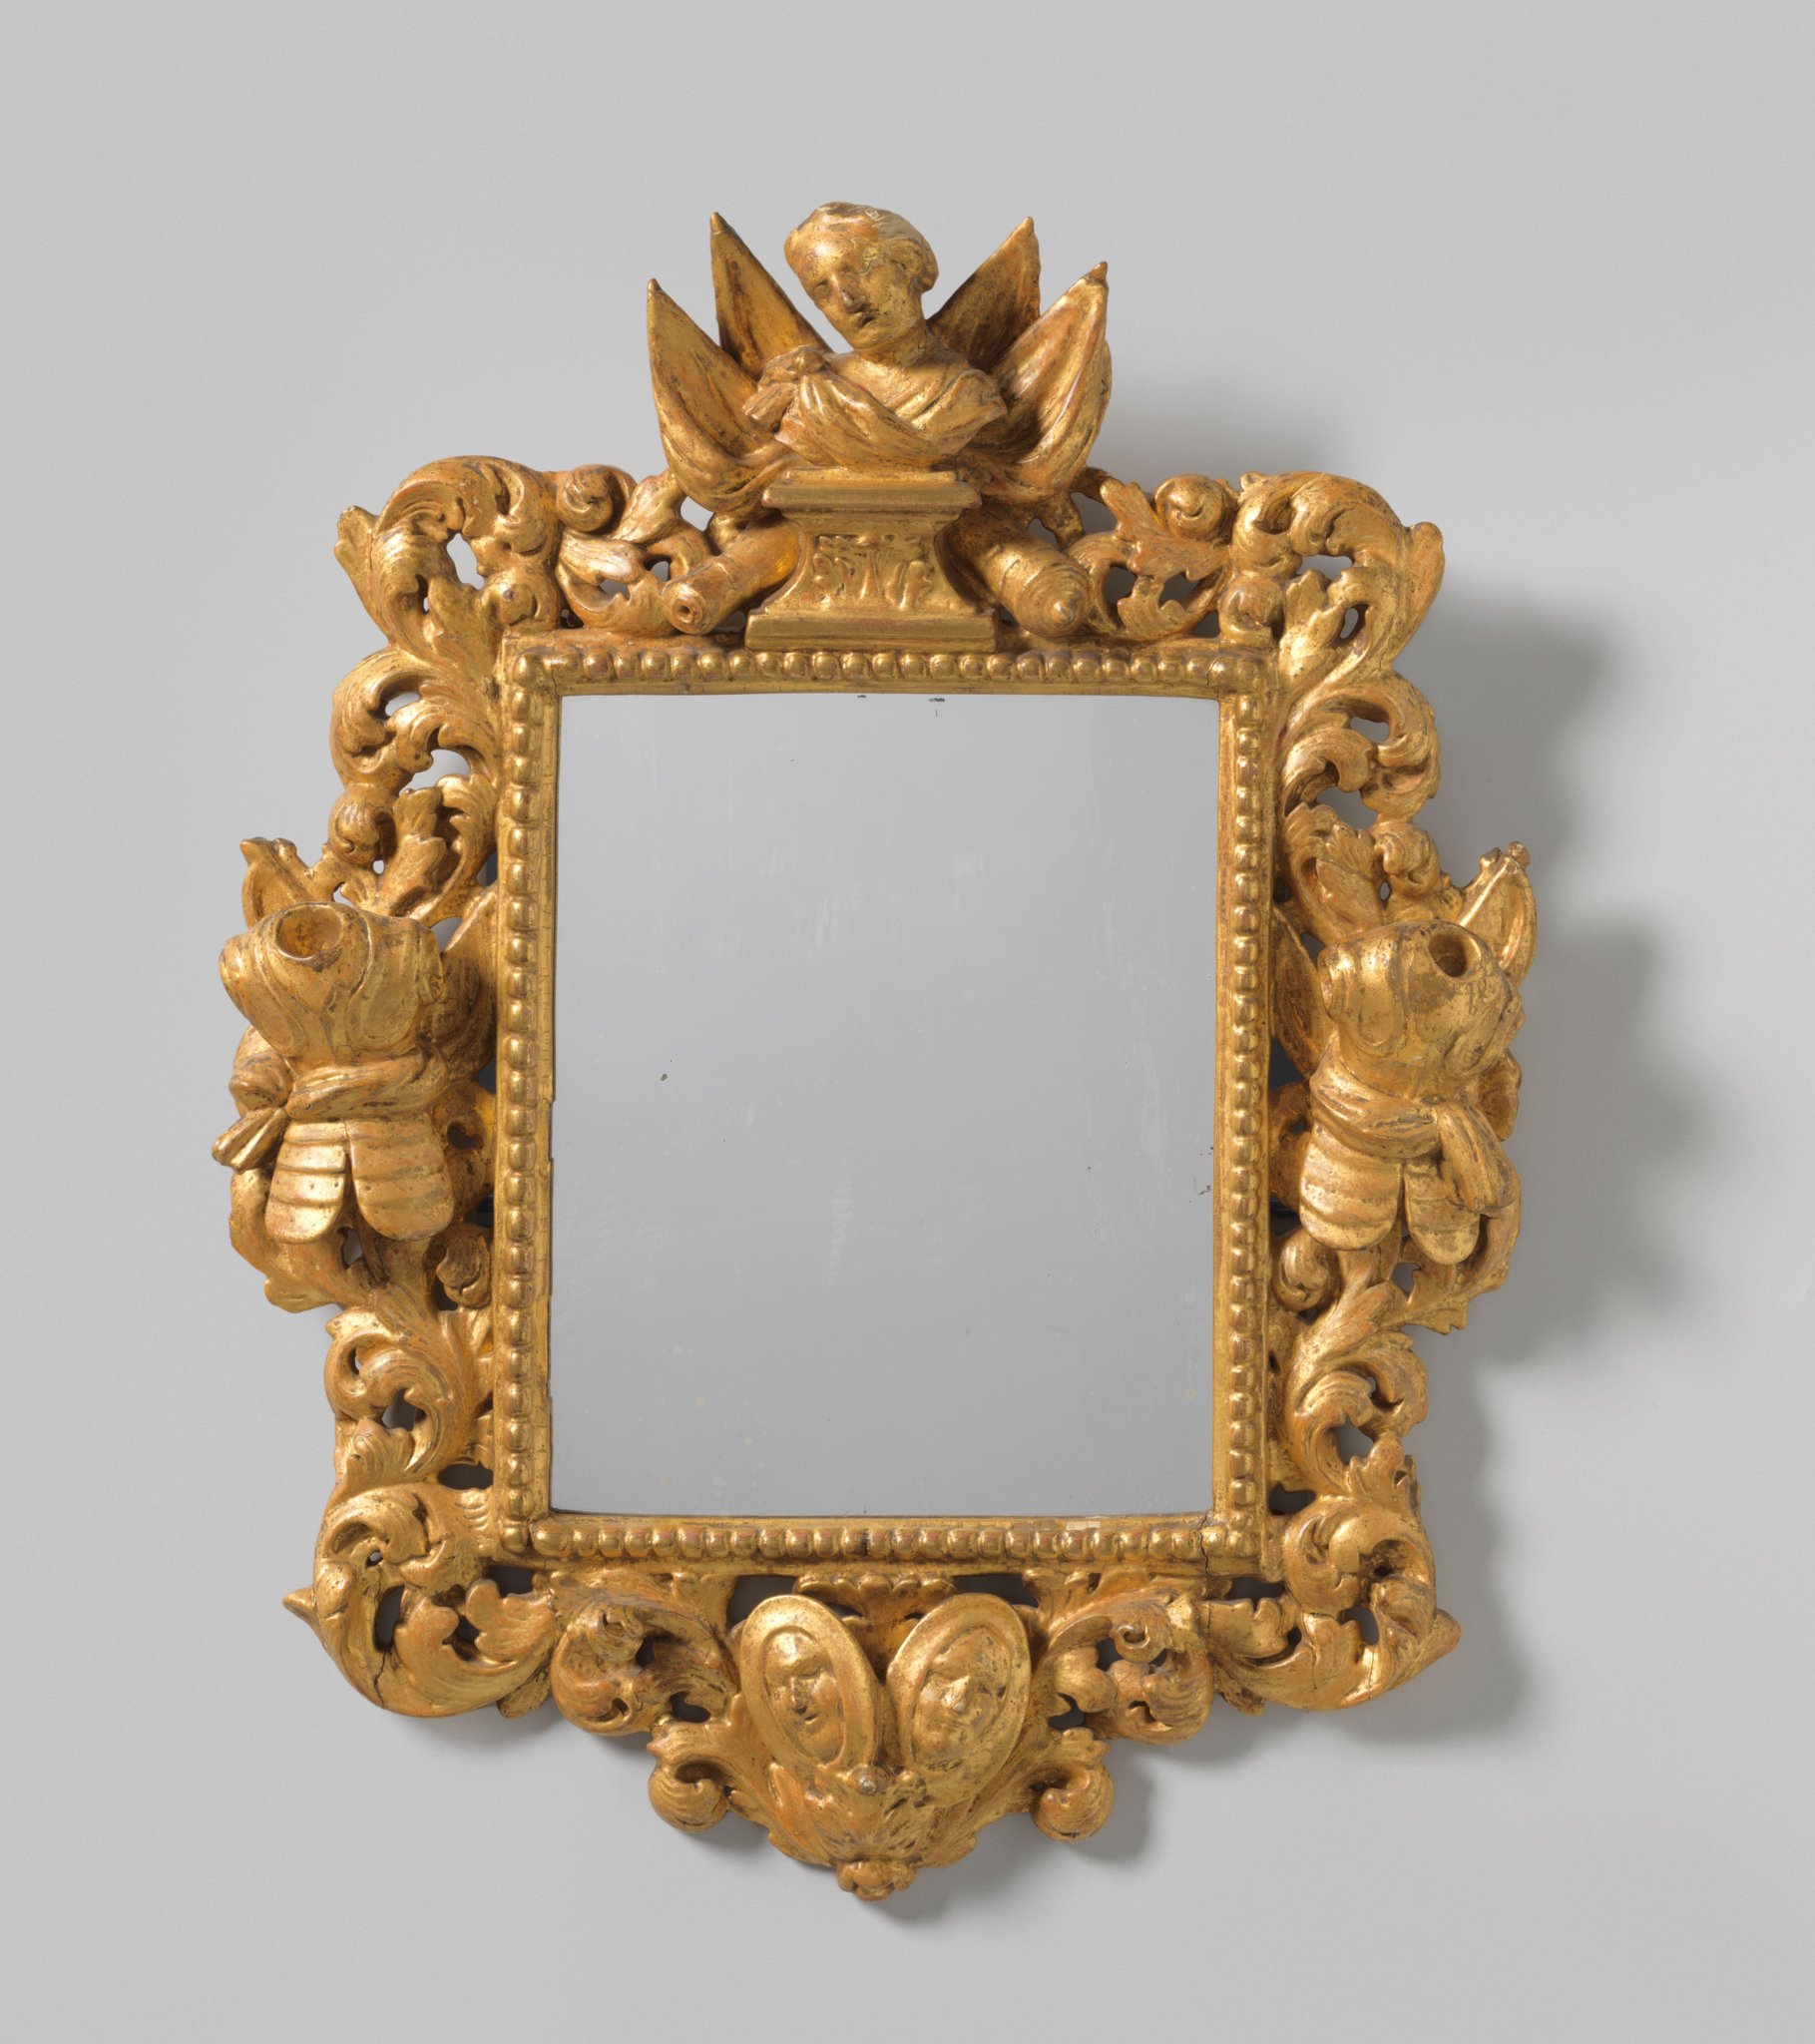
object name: frame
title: Lijst van verguld hout met snijwerk met spiegel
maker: Anonymous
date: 1700-1725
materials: amalgam, glass, wood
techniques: gilding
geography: northern netherlands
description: Pair of frames. Limewood, gilded. Netherlands, c. 1700.